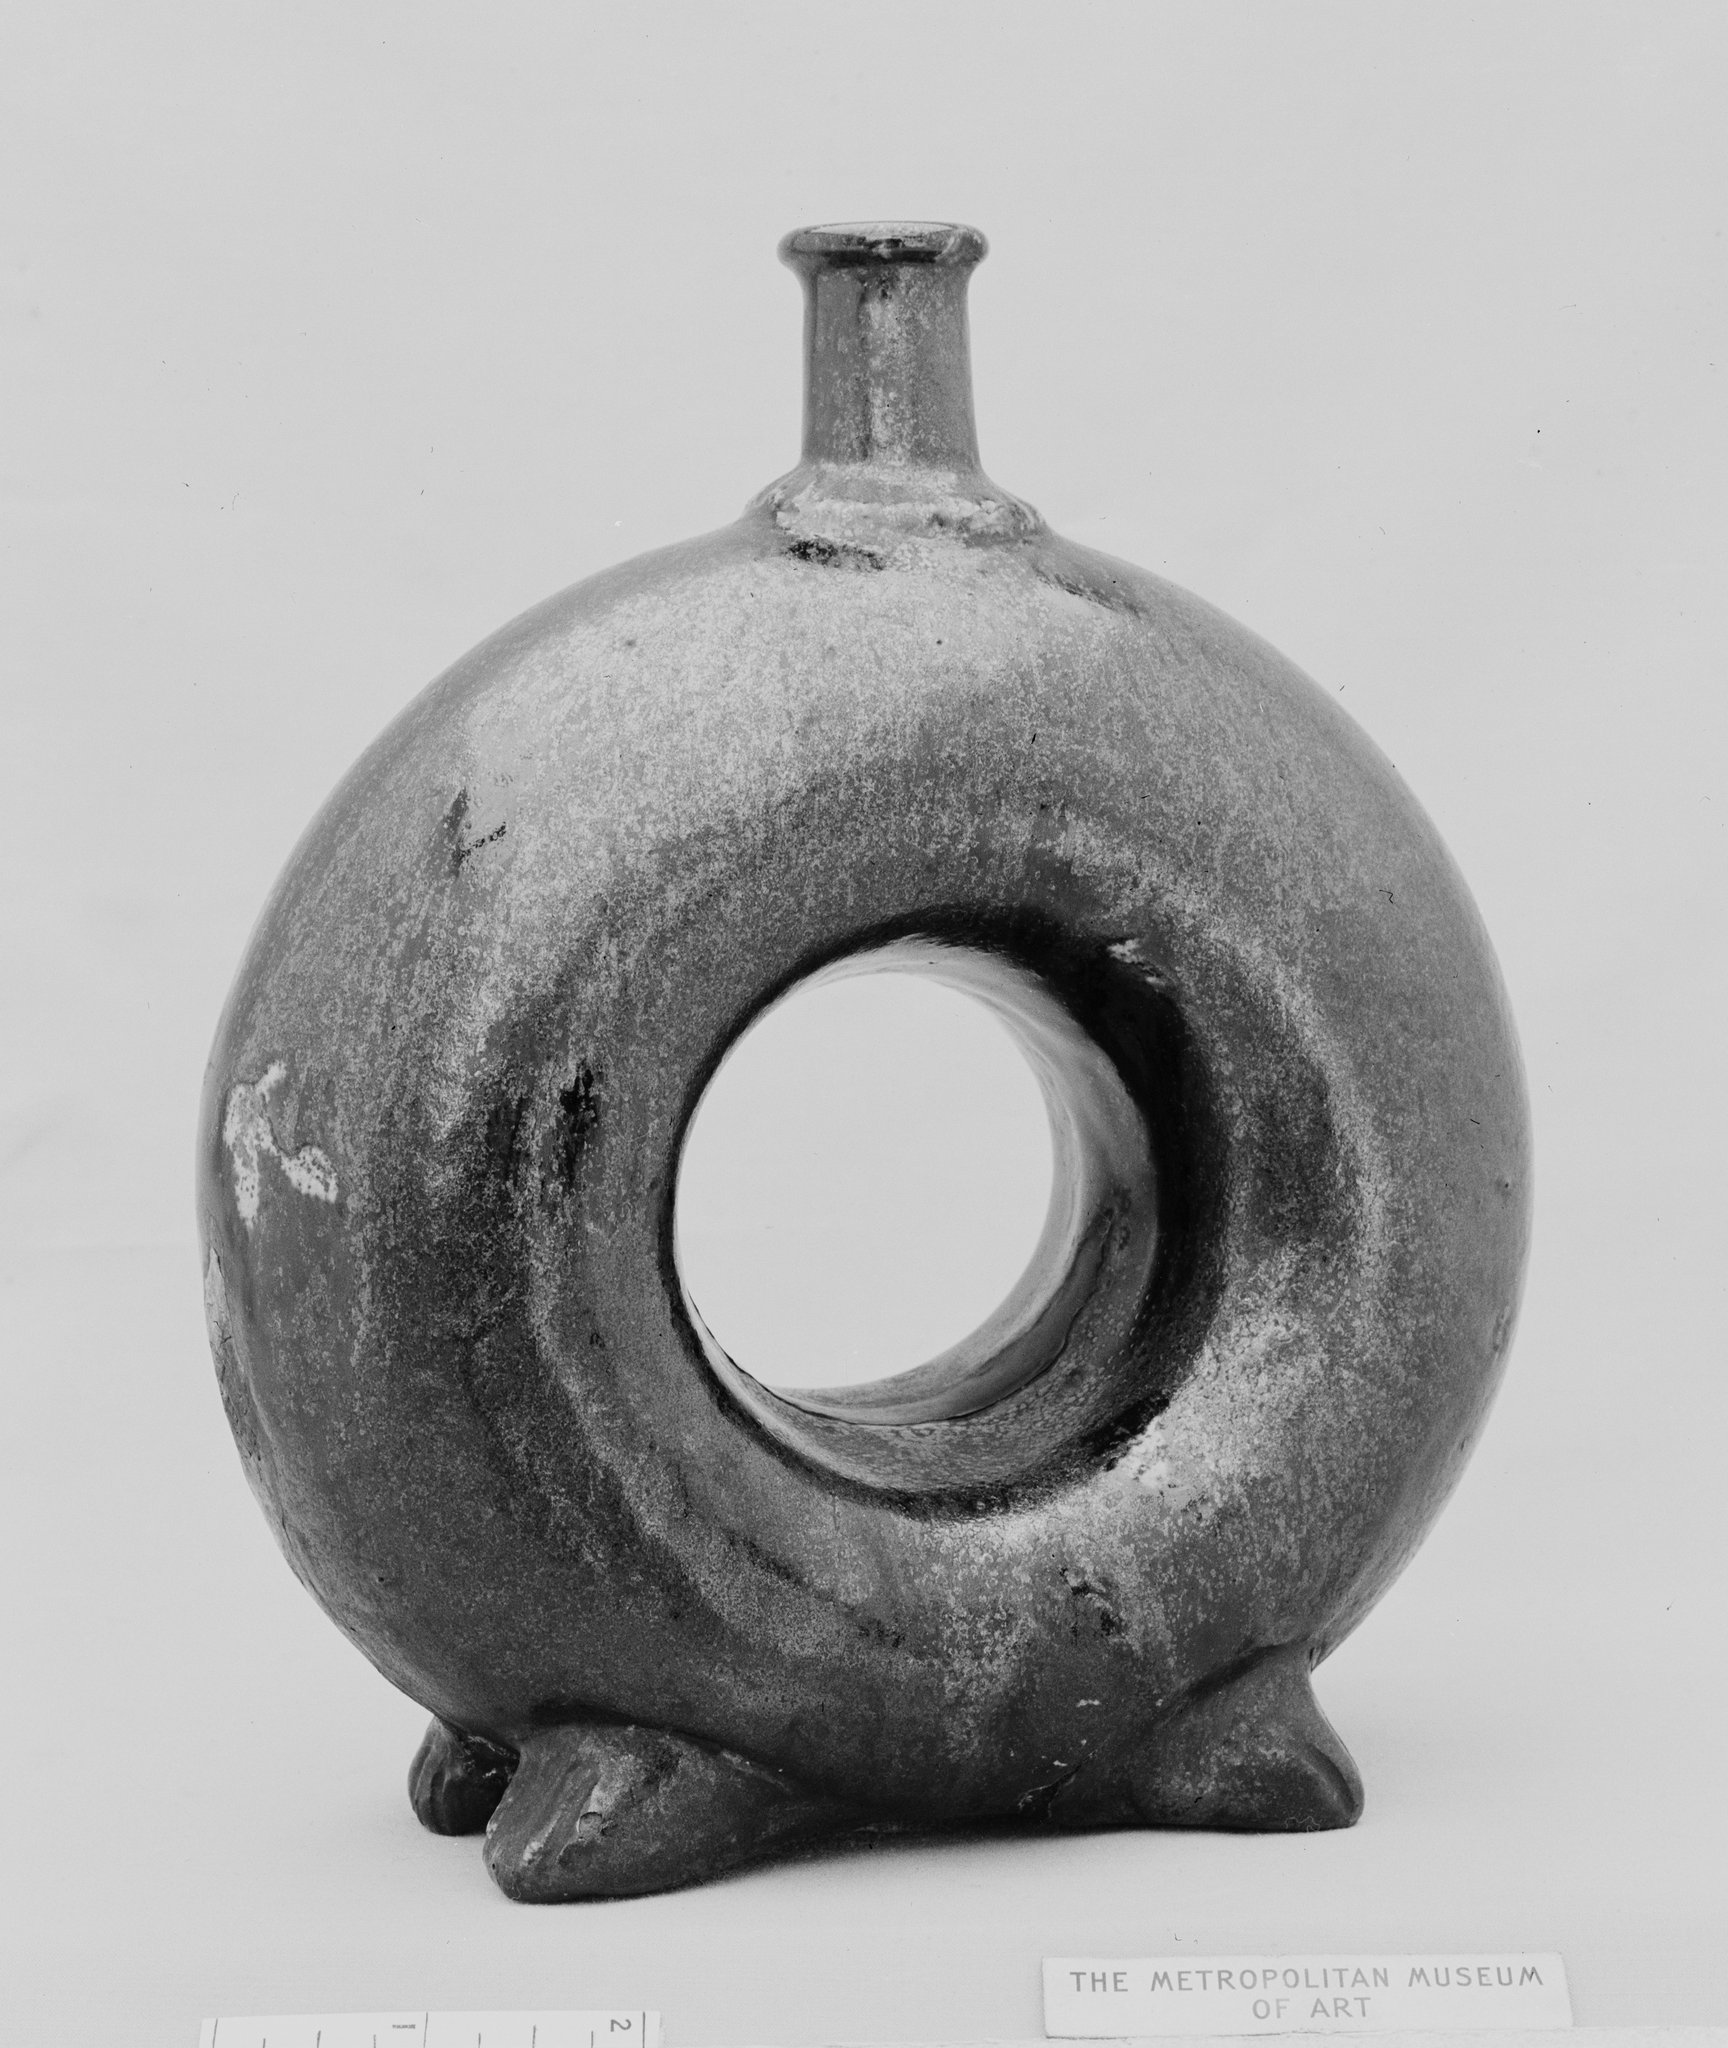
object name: bottle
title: Ring Bottle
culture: japanese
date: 1701-1800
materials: glaze, paste